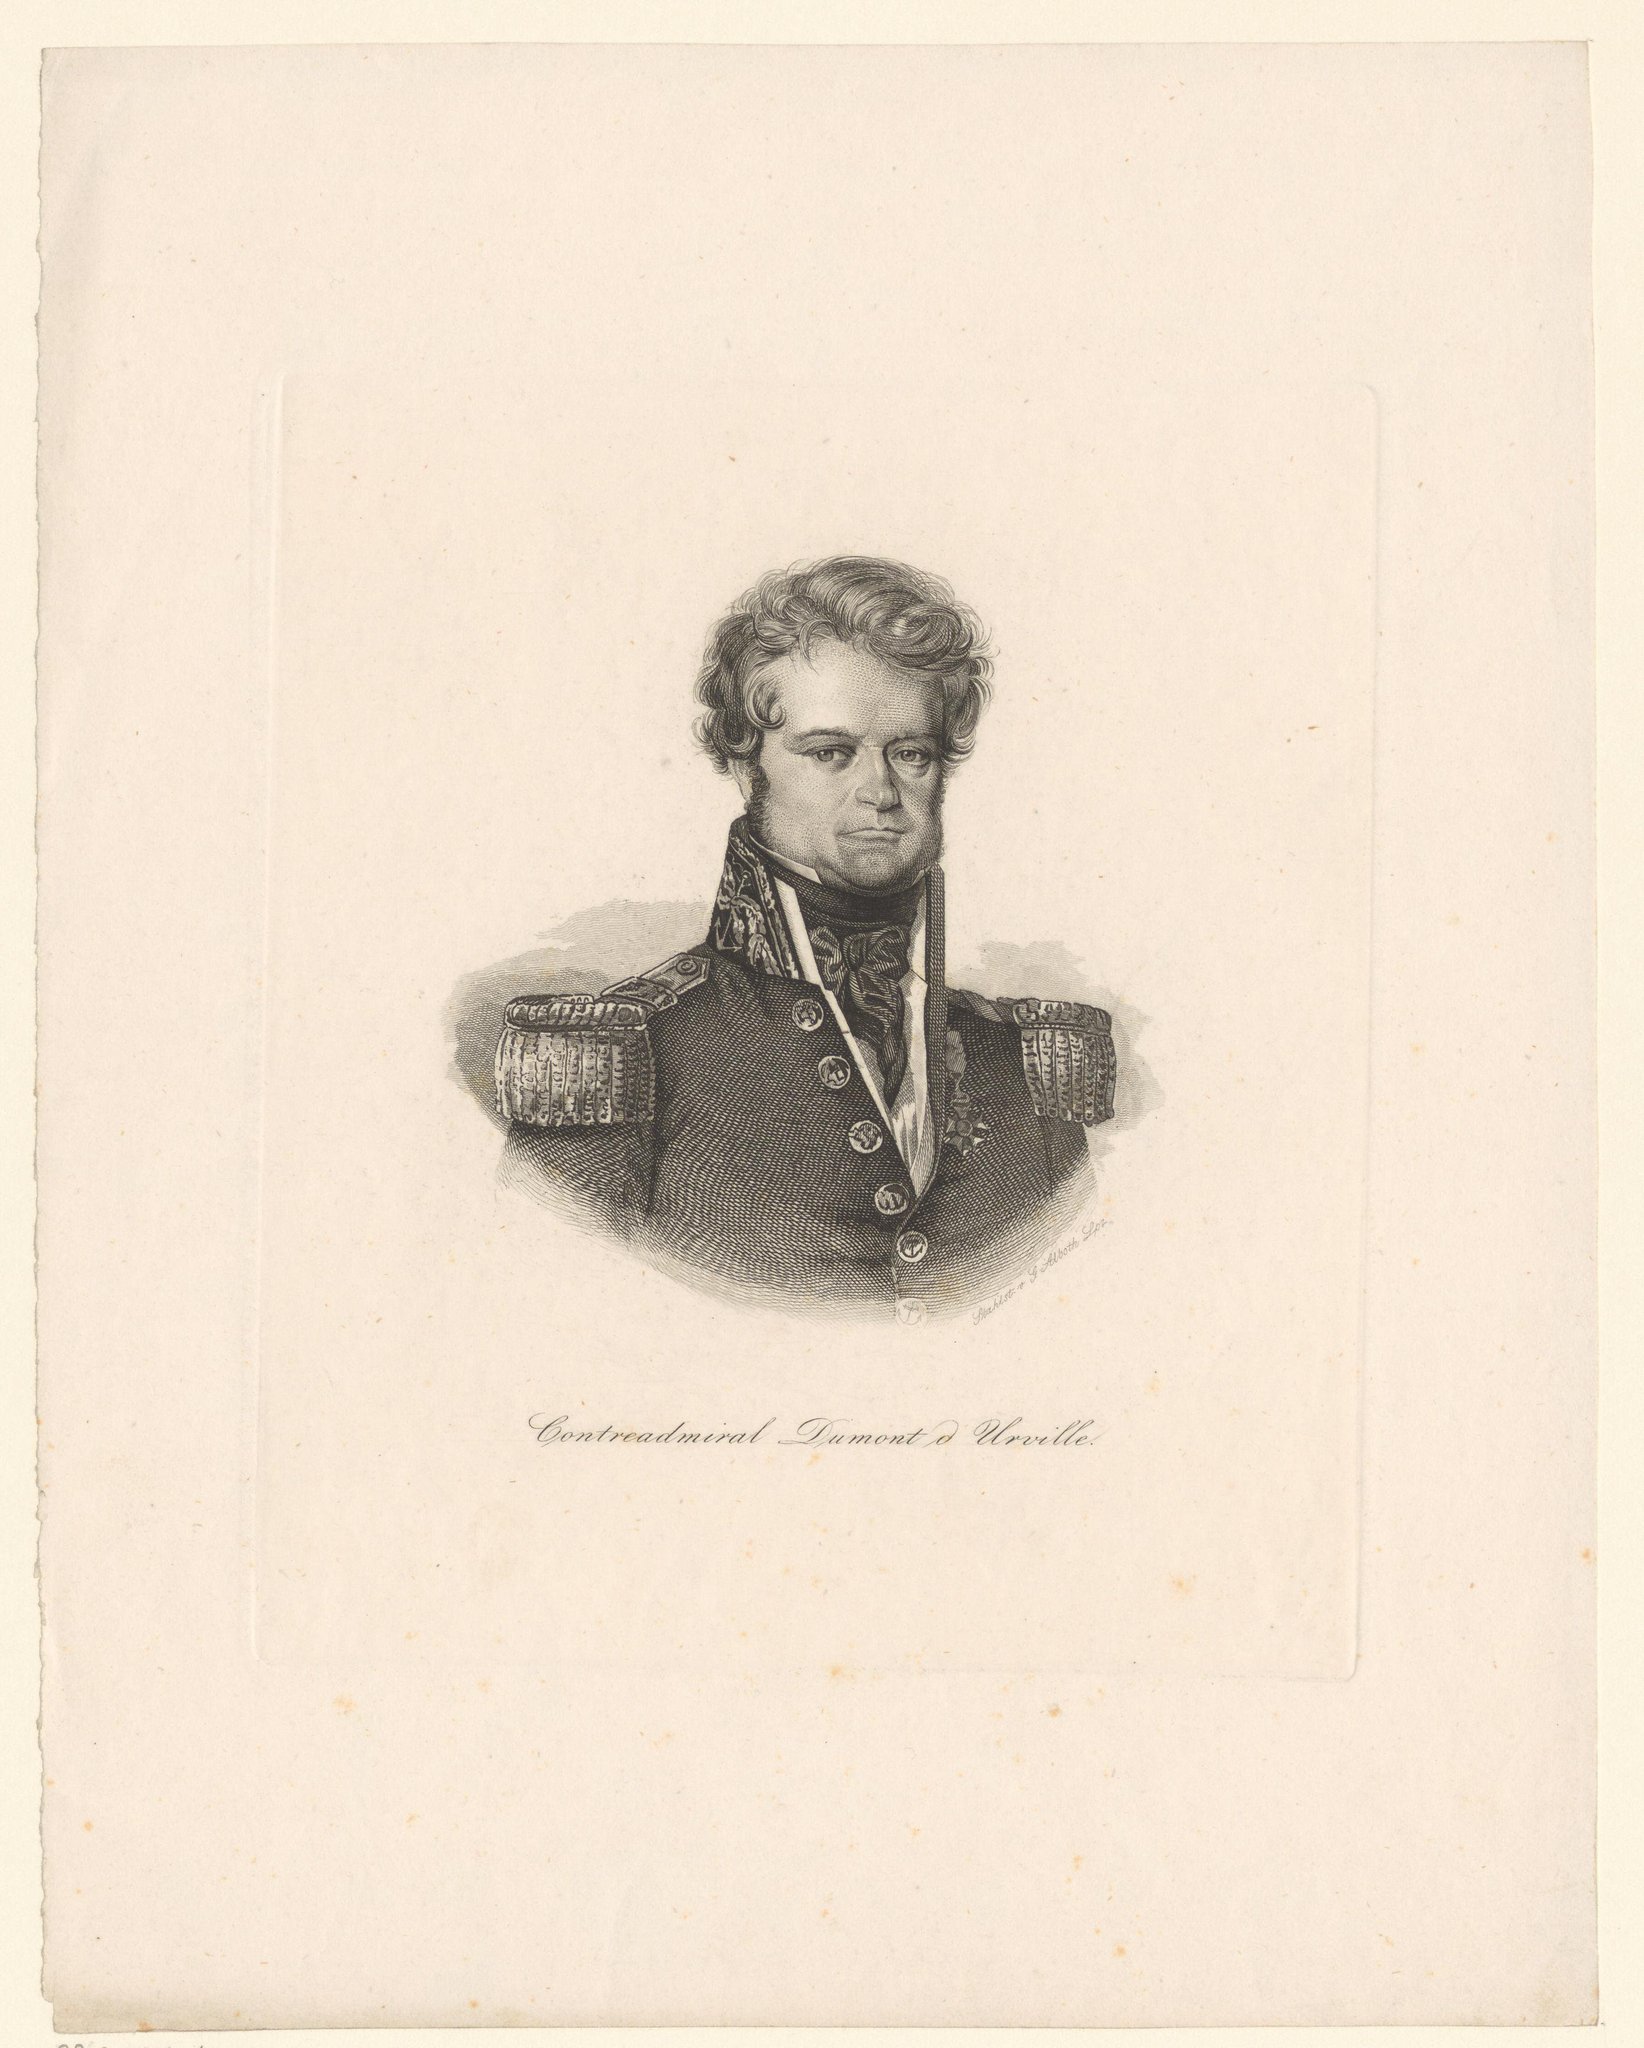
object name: print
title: Portret van Jules Dumont d'Urville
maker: gustav robert alboth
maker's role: print maker, printer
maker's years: 1817-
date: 1827-1910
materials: paper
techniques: etching, engraving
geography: leipzig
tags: historical persons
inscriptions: collector's mark: Lugt 2228